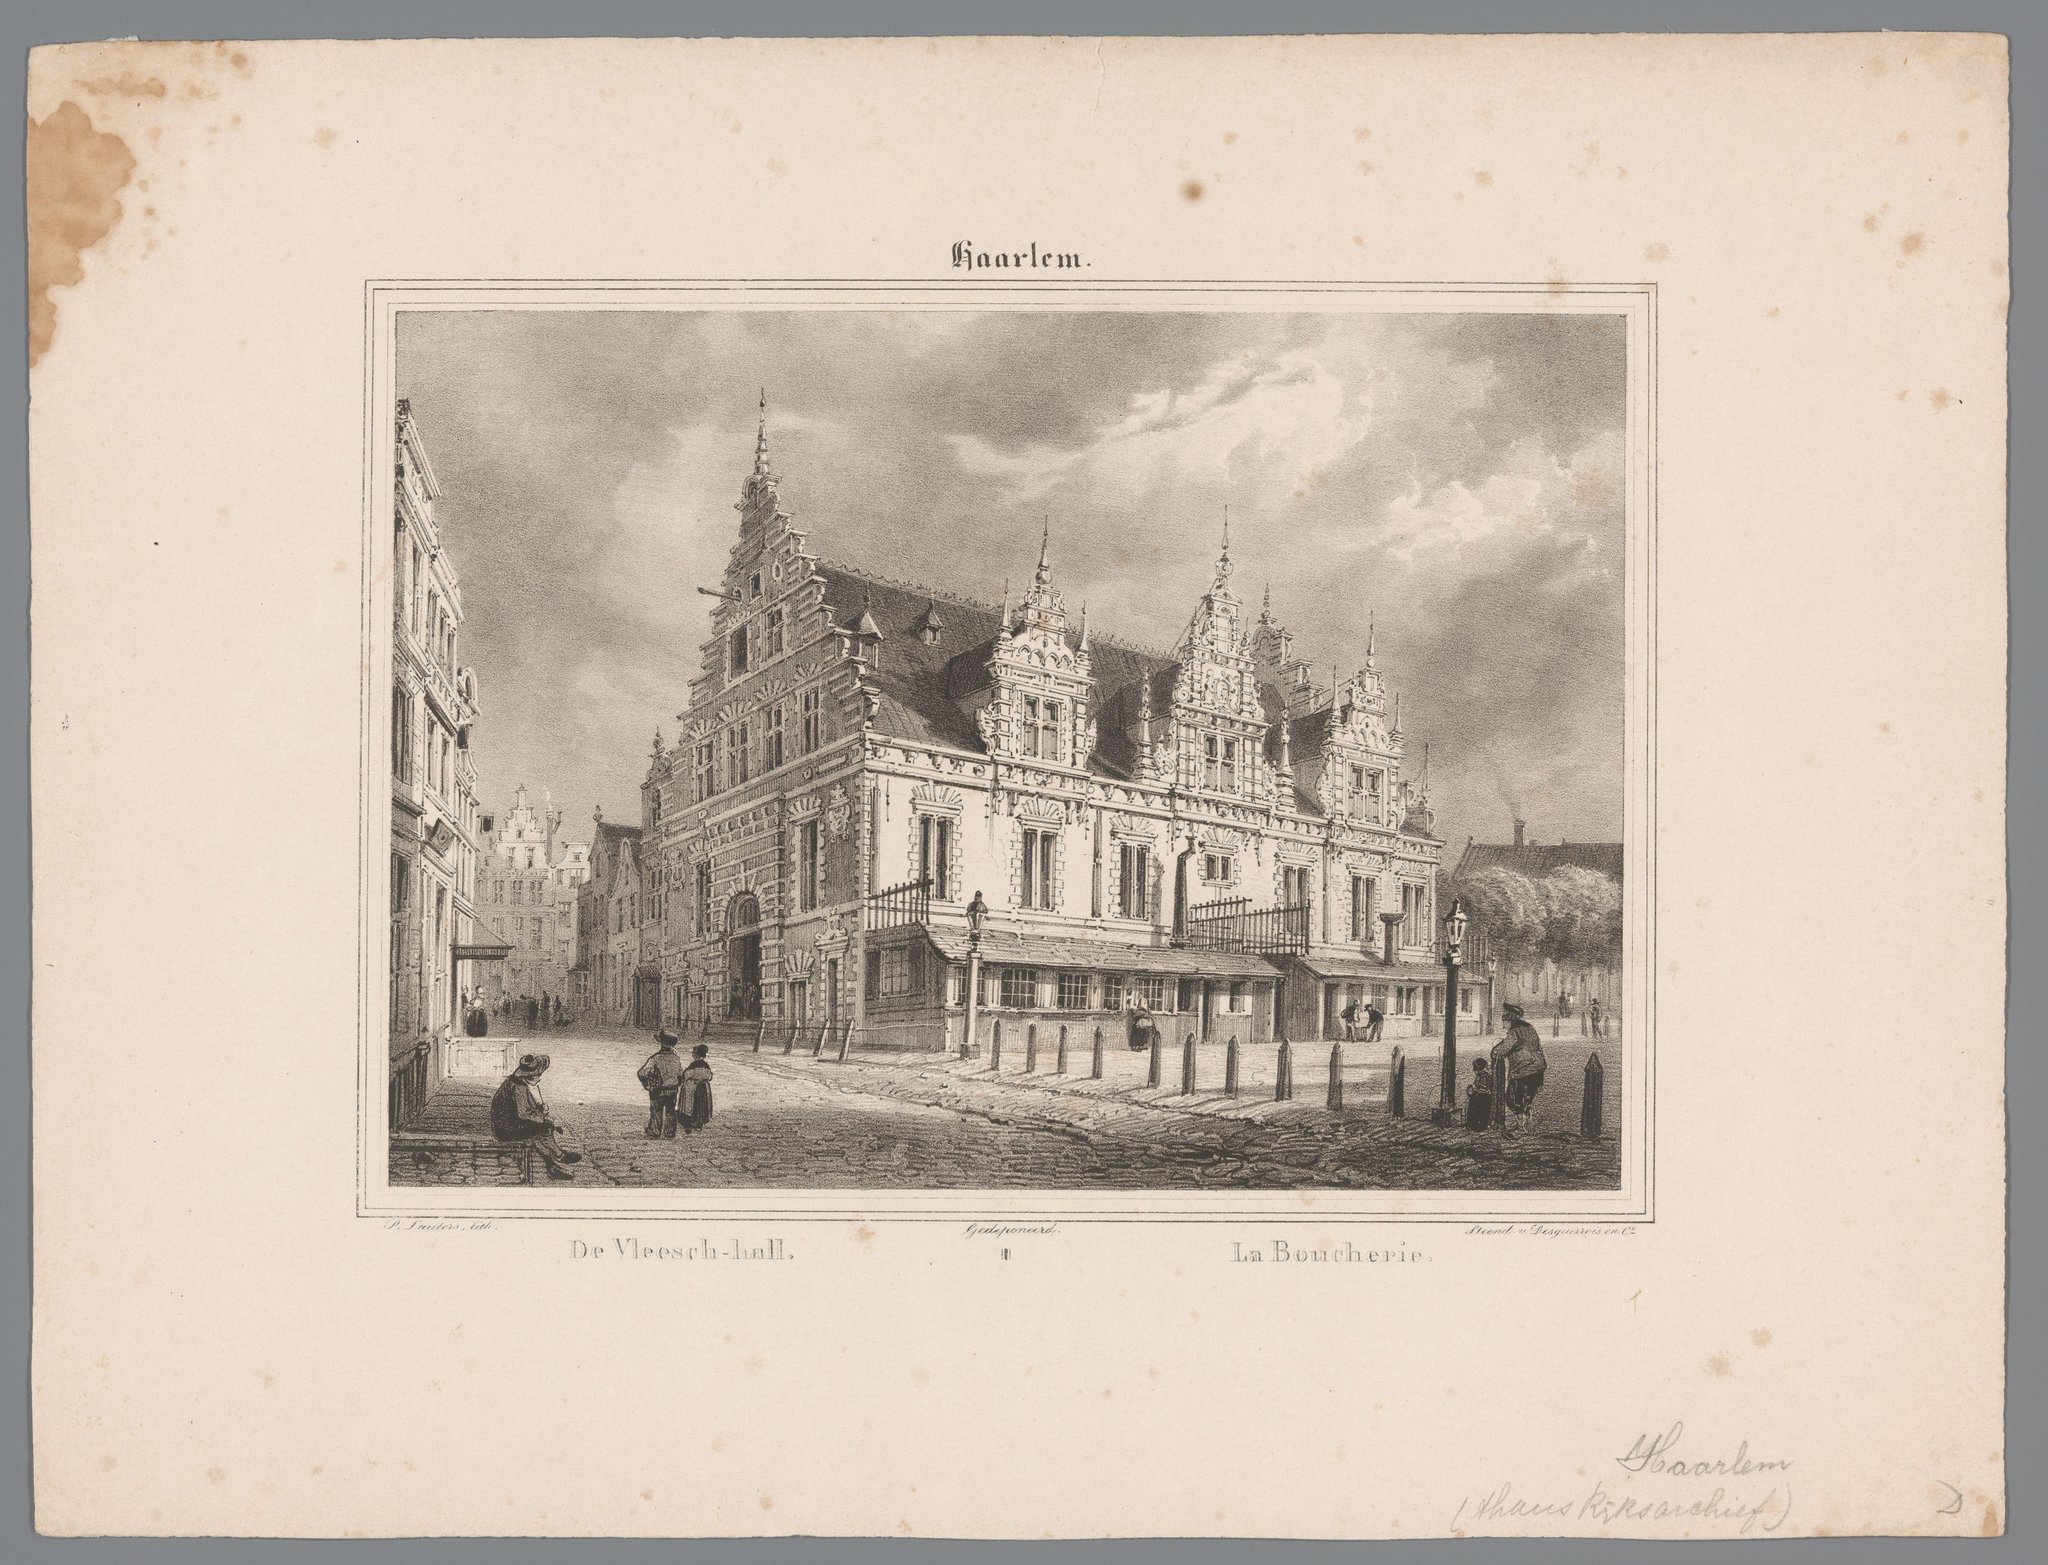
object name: print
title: De Vleesch-hall / La Boucherie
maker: paulus lauters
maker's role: print maker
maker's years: 1806-1875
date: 1827-1900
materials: paper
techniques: lithograph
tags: market-hall, edifice, e.g.: public building, department store